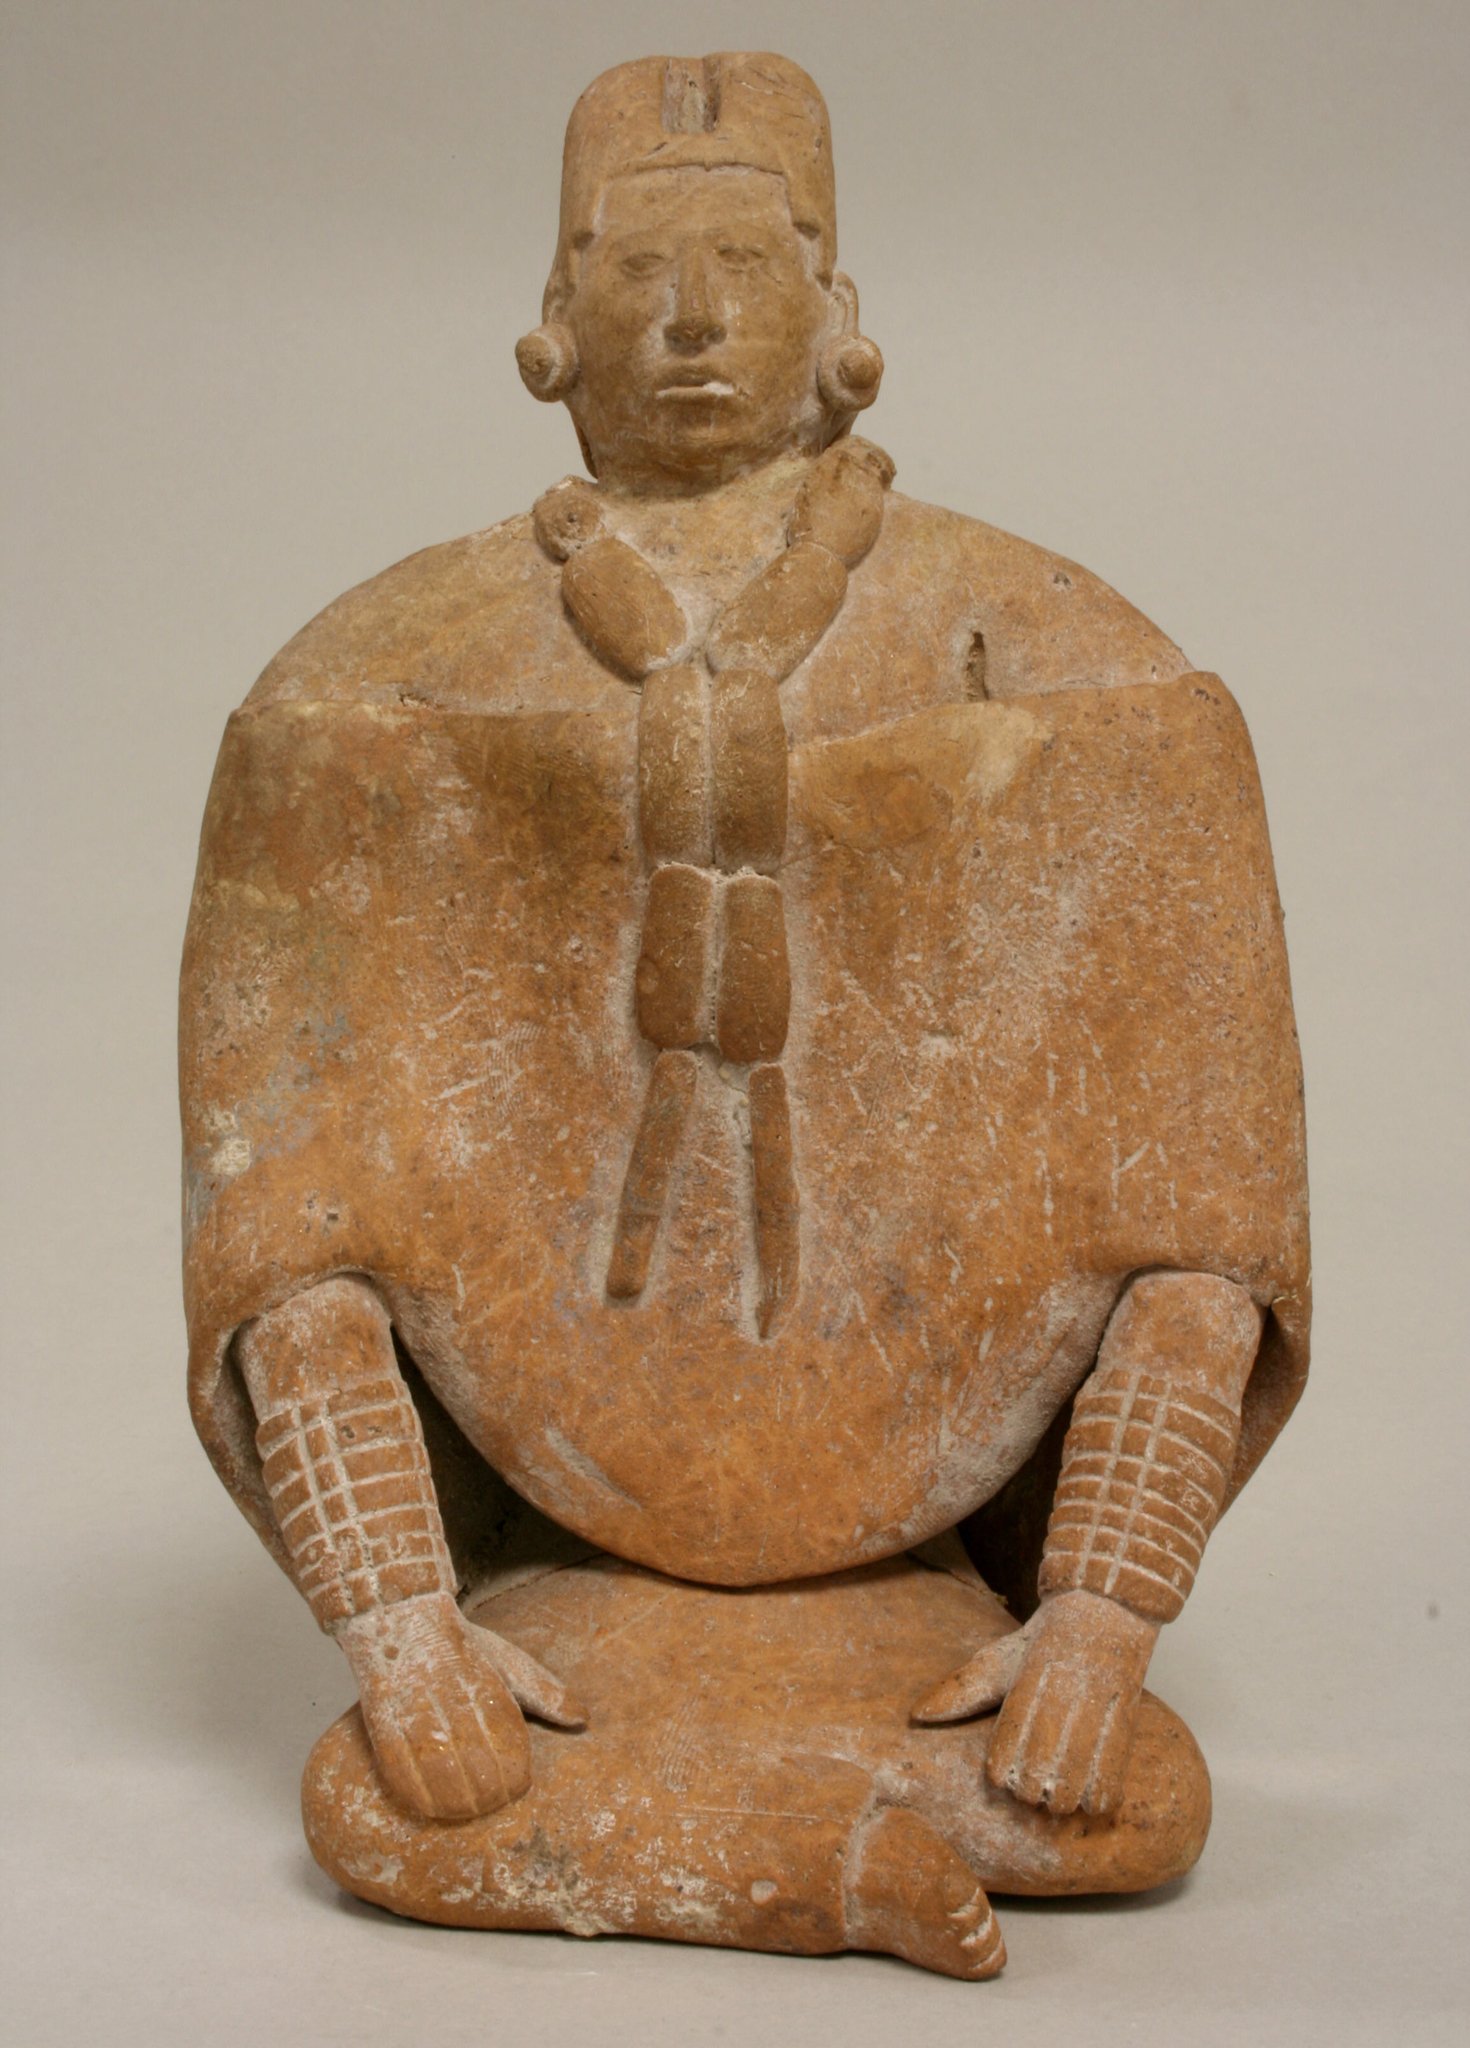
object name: female figure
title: Seated Female Figure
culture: maya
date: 501-900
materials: ceramic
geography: mexico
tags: women